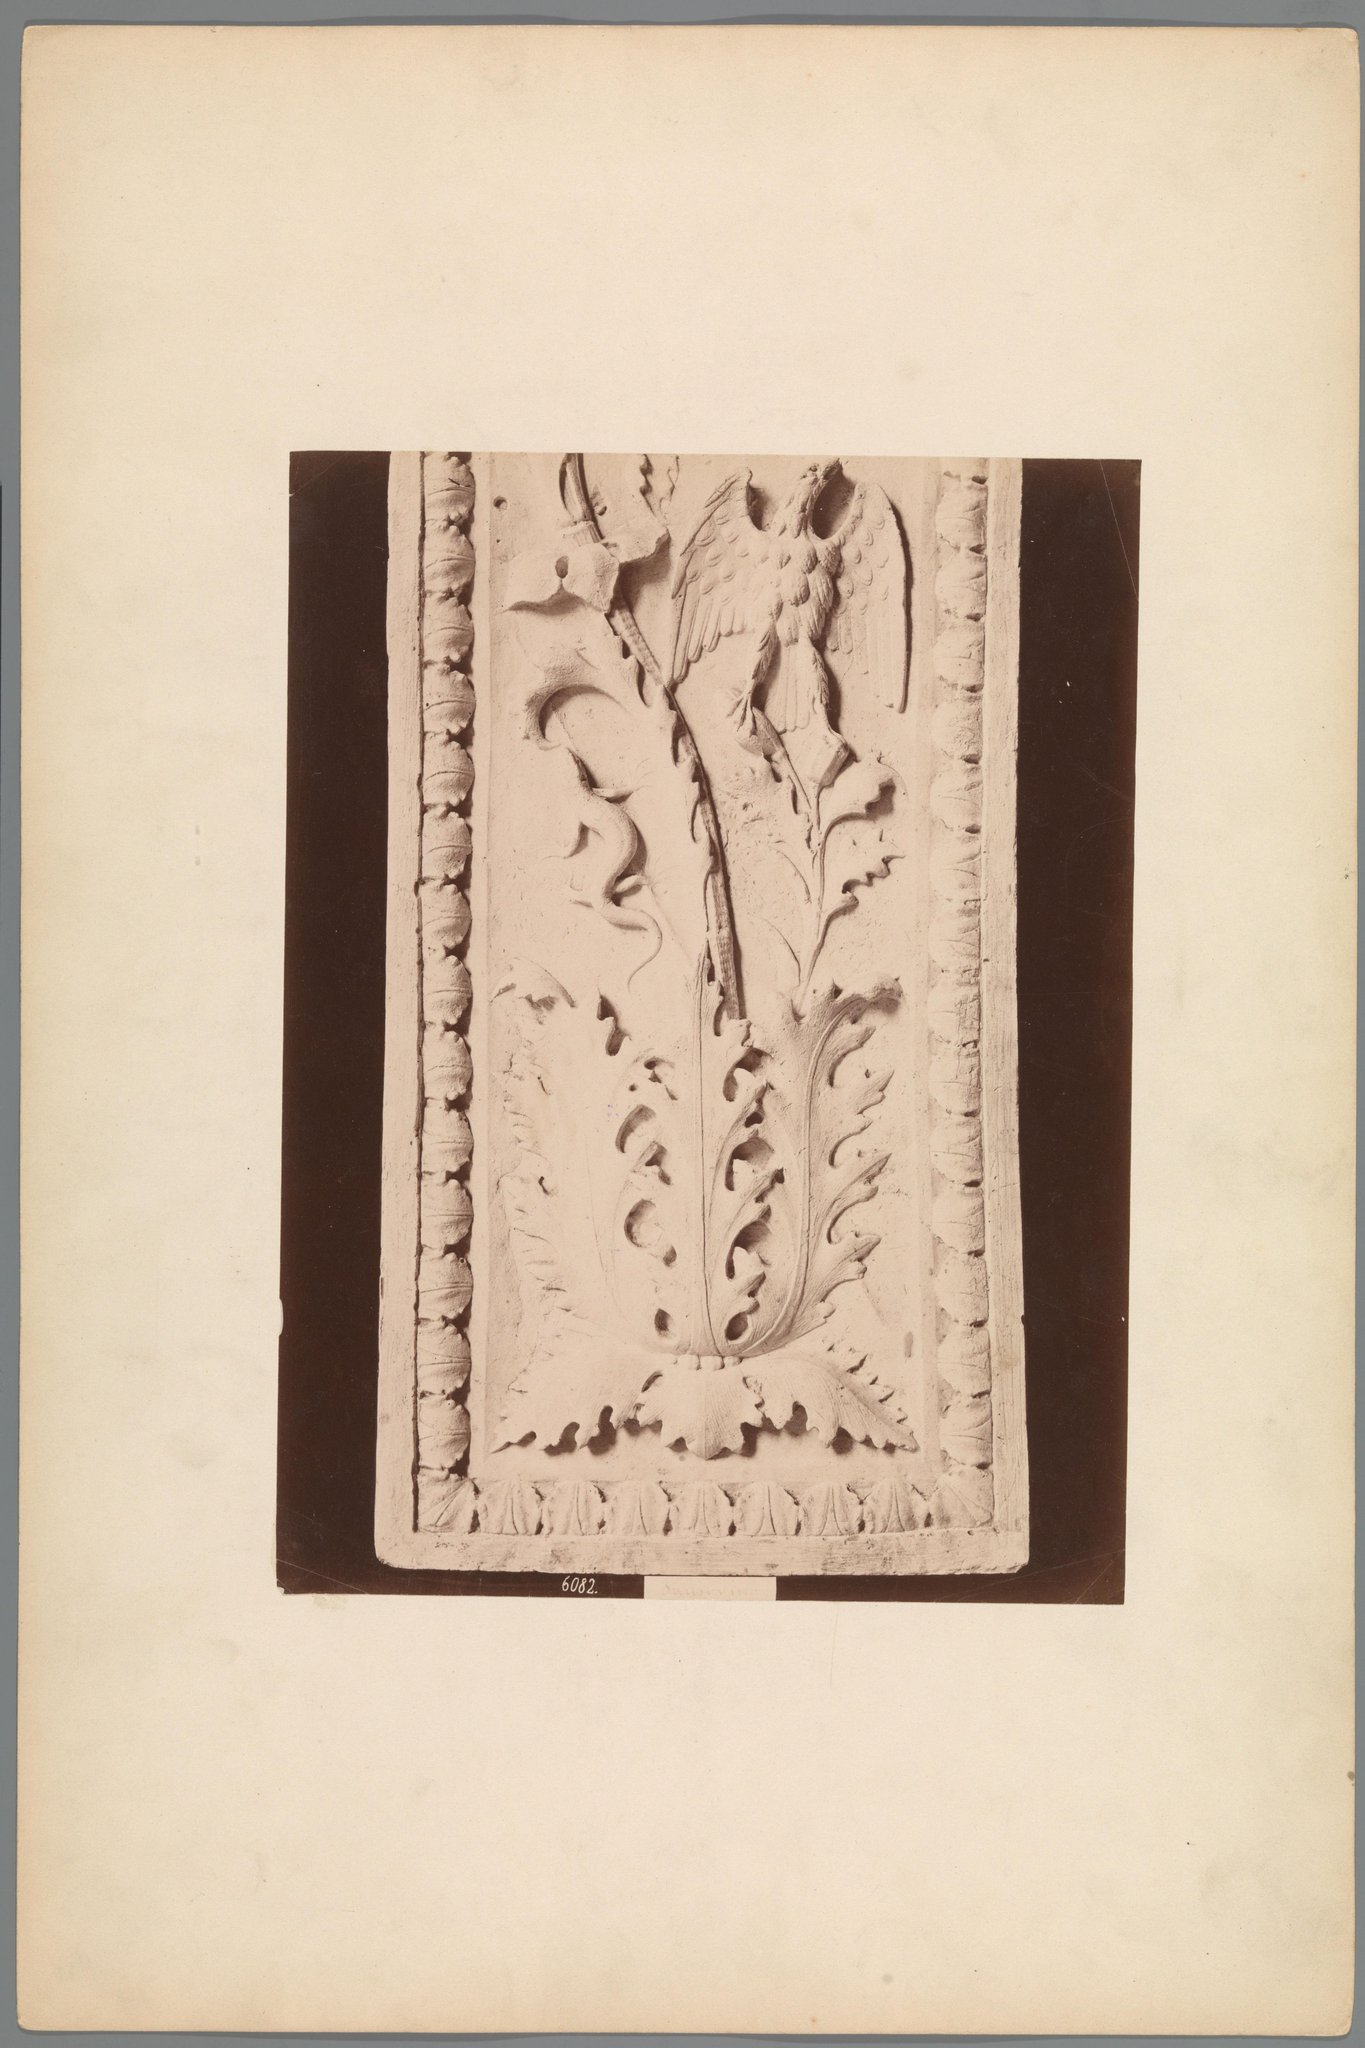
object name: photograph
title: Reliëf met acanthusbladeren en een adelaar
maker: Anonymous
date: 1875-1900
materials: cardboard, photographic support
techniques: albumen print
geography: europe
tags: acanthus ~ ornament, predatory birds: eagle, sculpture (+ relief ~ sculpture), europe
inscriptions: number: ‘6082.’, collector's mark: Lugt 3937